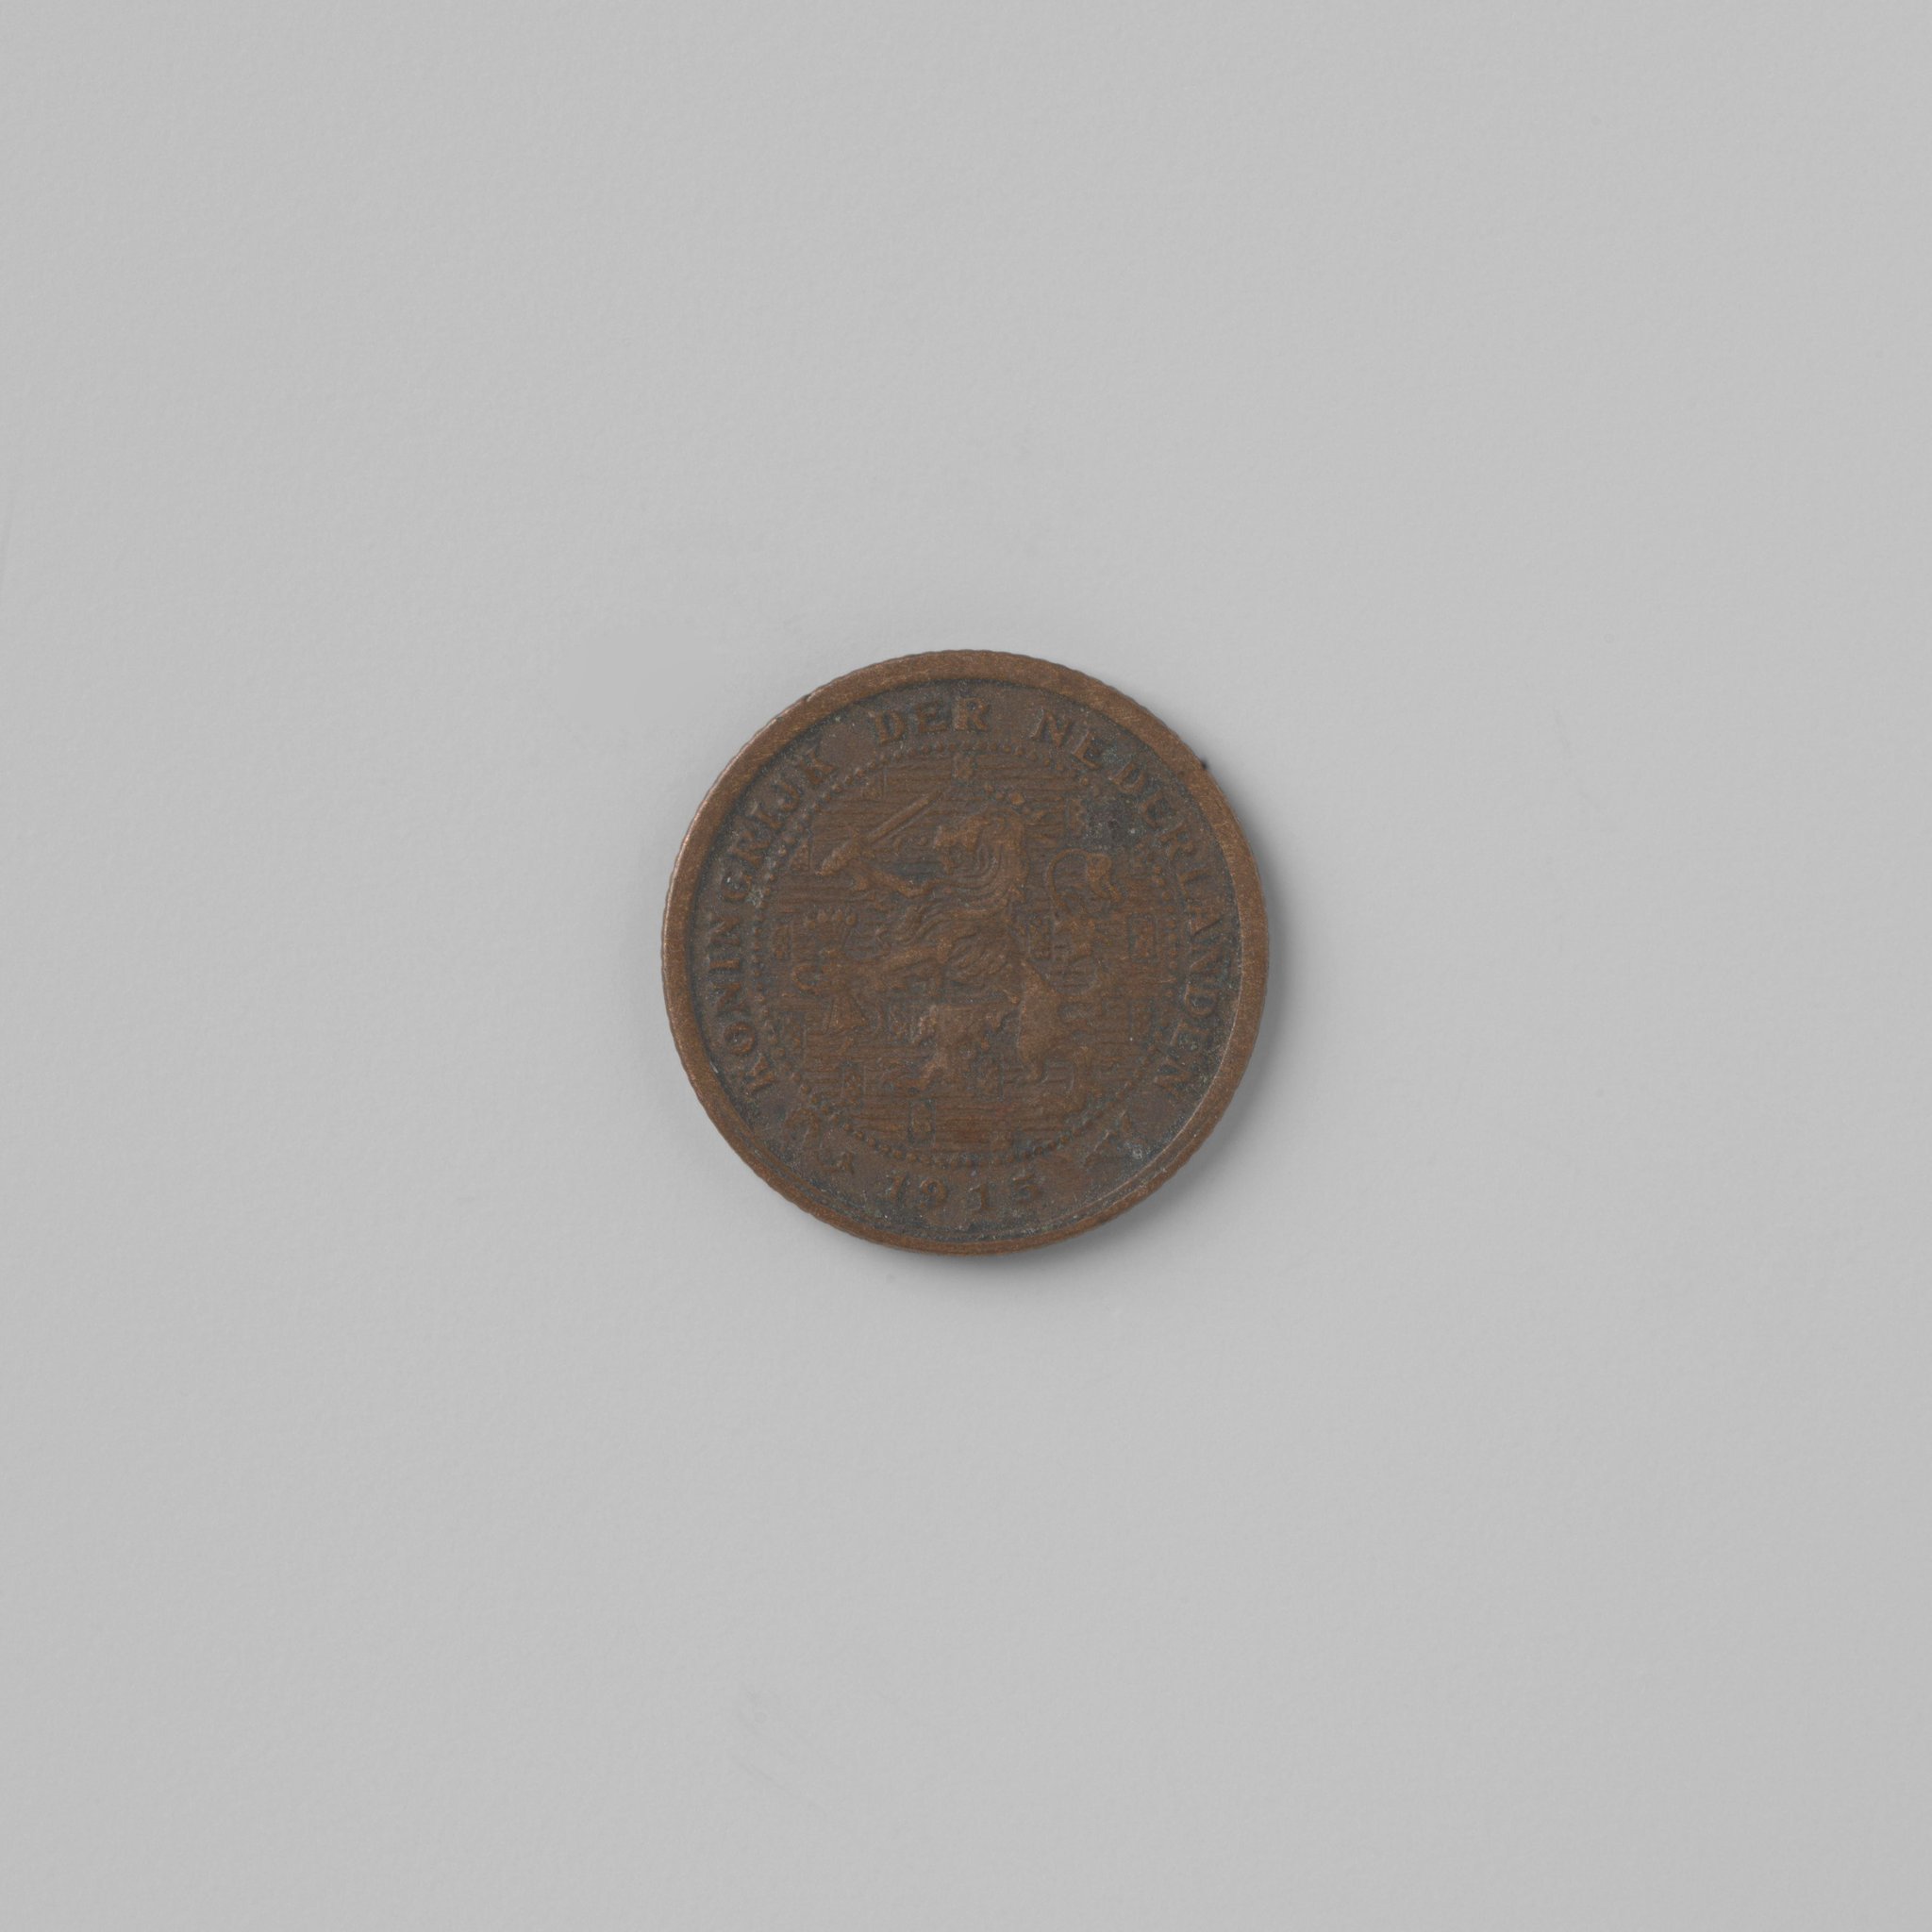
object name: coin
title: Nederland, ½ cent, 1915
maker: wilhelmina of the netherlands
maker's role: print maker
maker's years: 1880-1962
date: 1915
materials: bronze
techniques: striking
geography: utrecht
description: Bronzen munt. Voorzijde: in een veld rijkswapen. Jaartal onderaan in omschrift. Keerzijde: binnen twee samengebonden oranjetakken waarde-aanduiding ½ cent. Kartelrand.